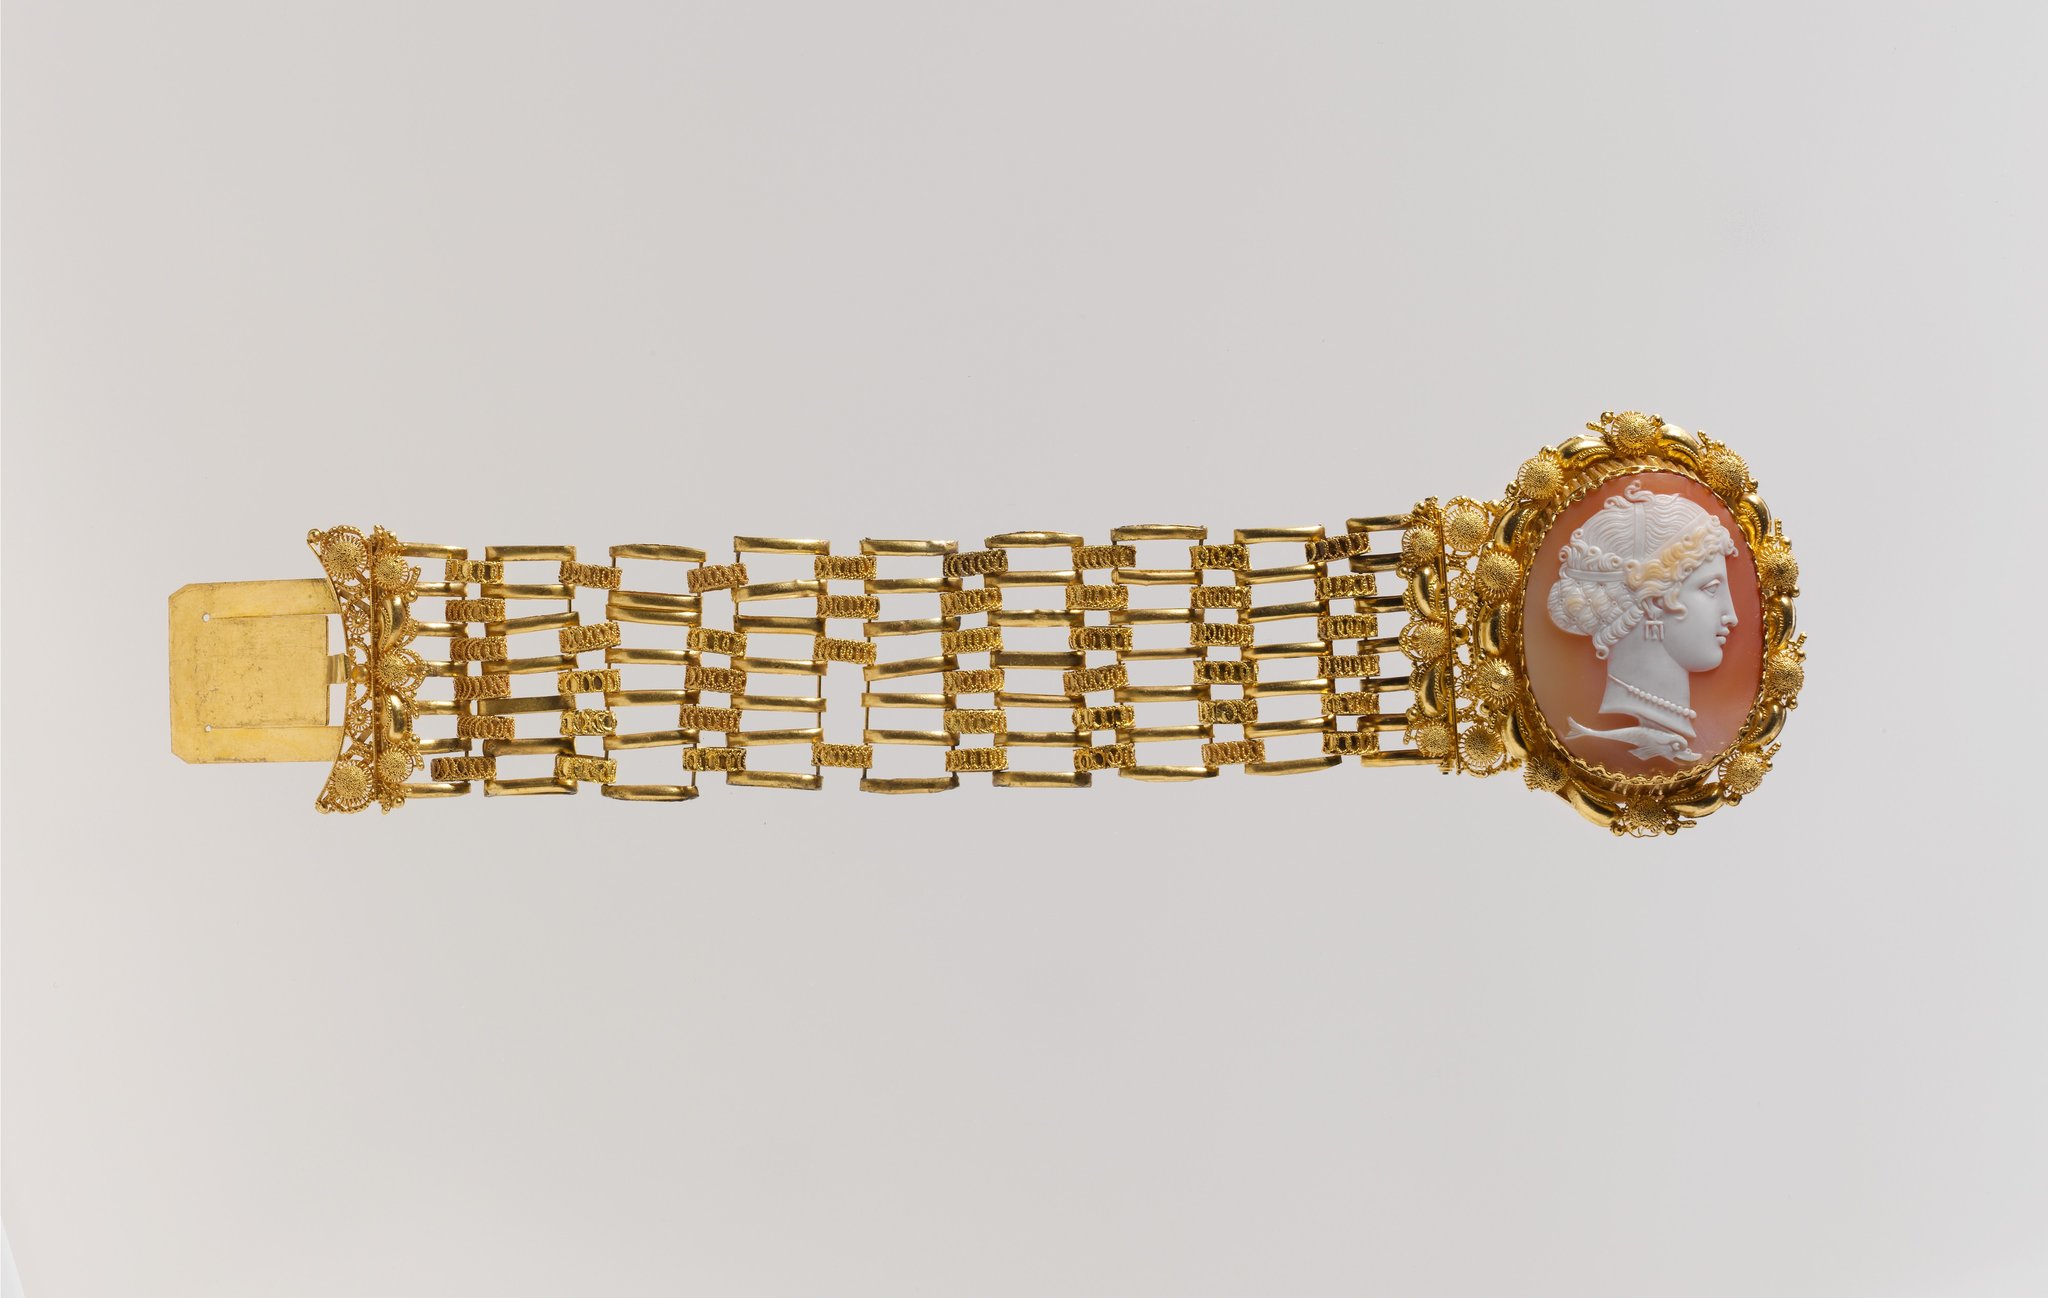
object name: bracelet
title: Bracelet (part of a set)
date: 1834-1866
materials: gold, shell